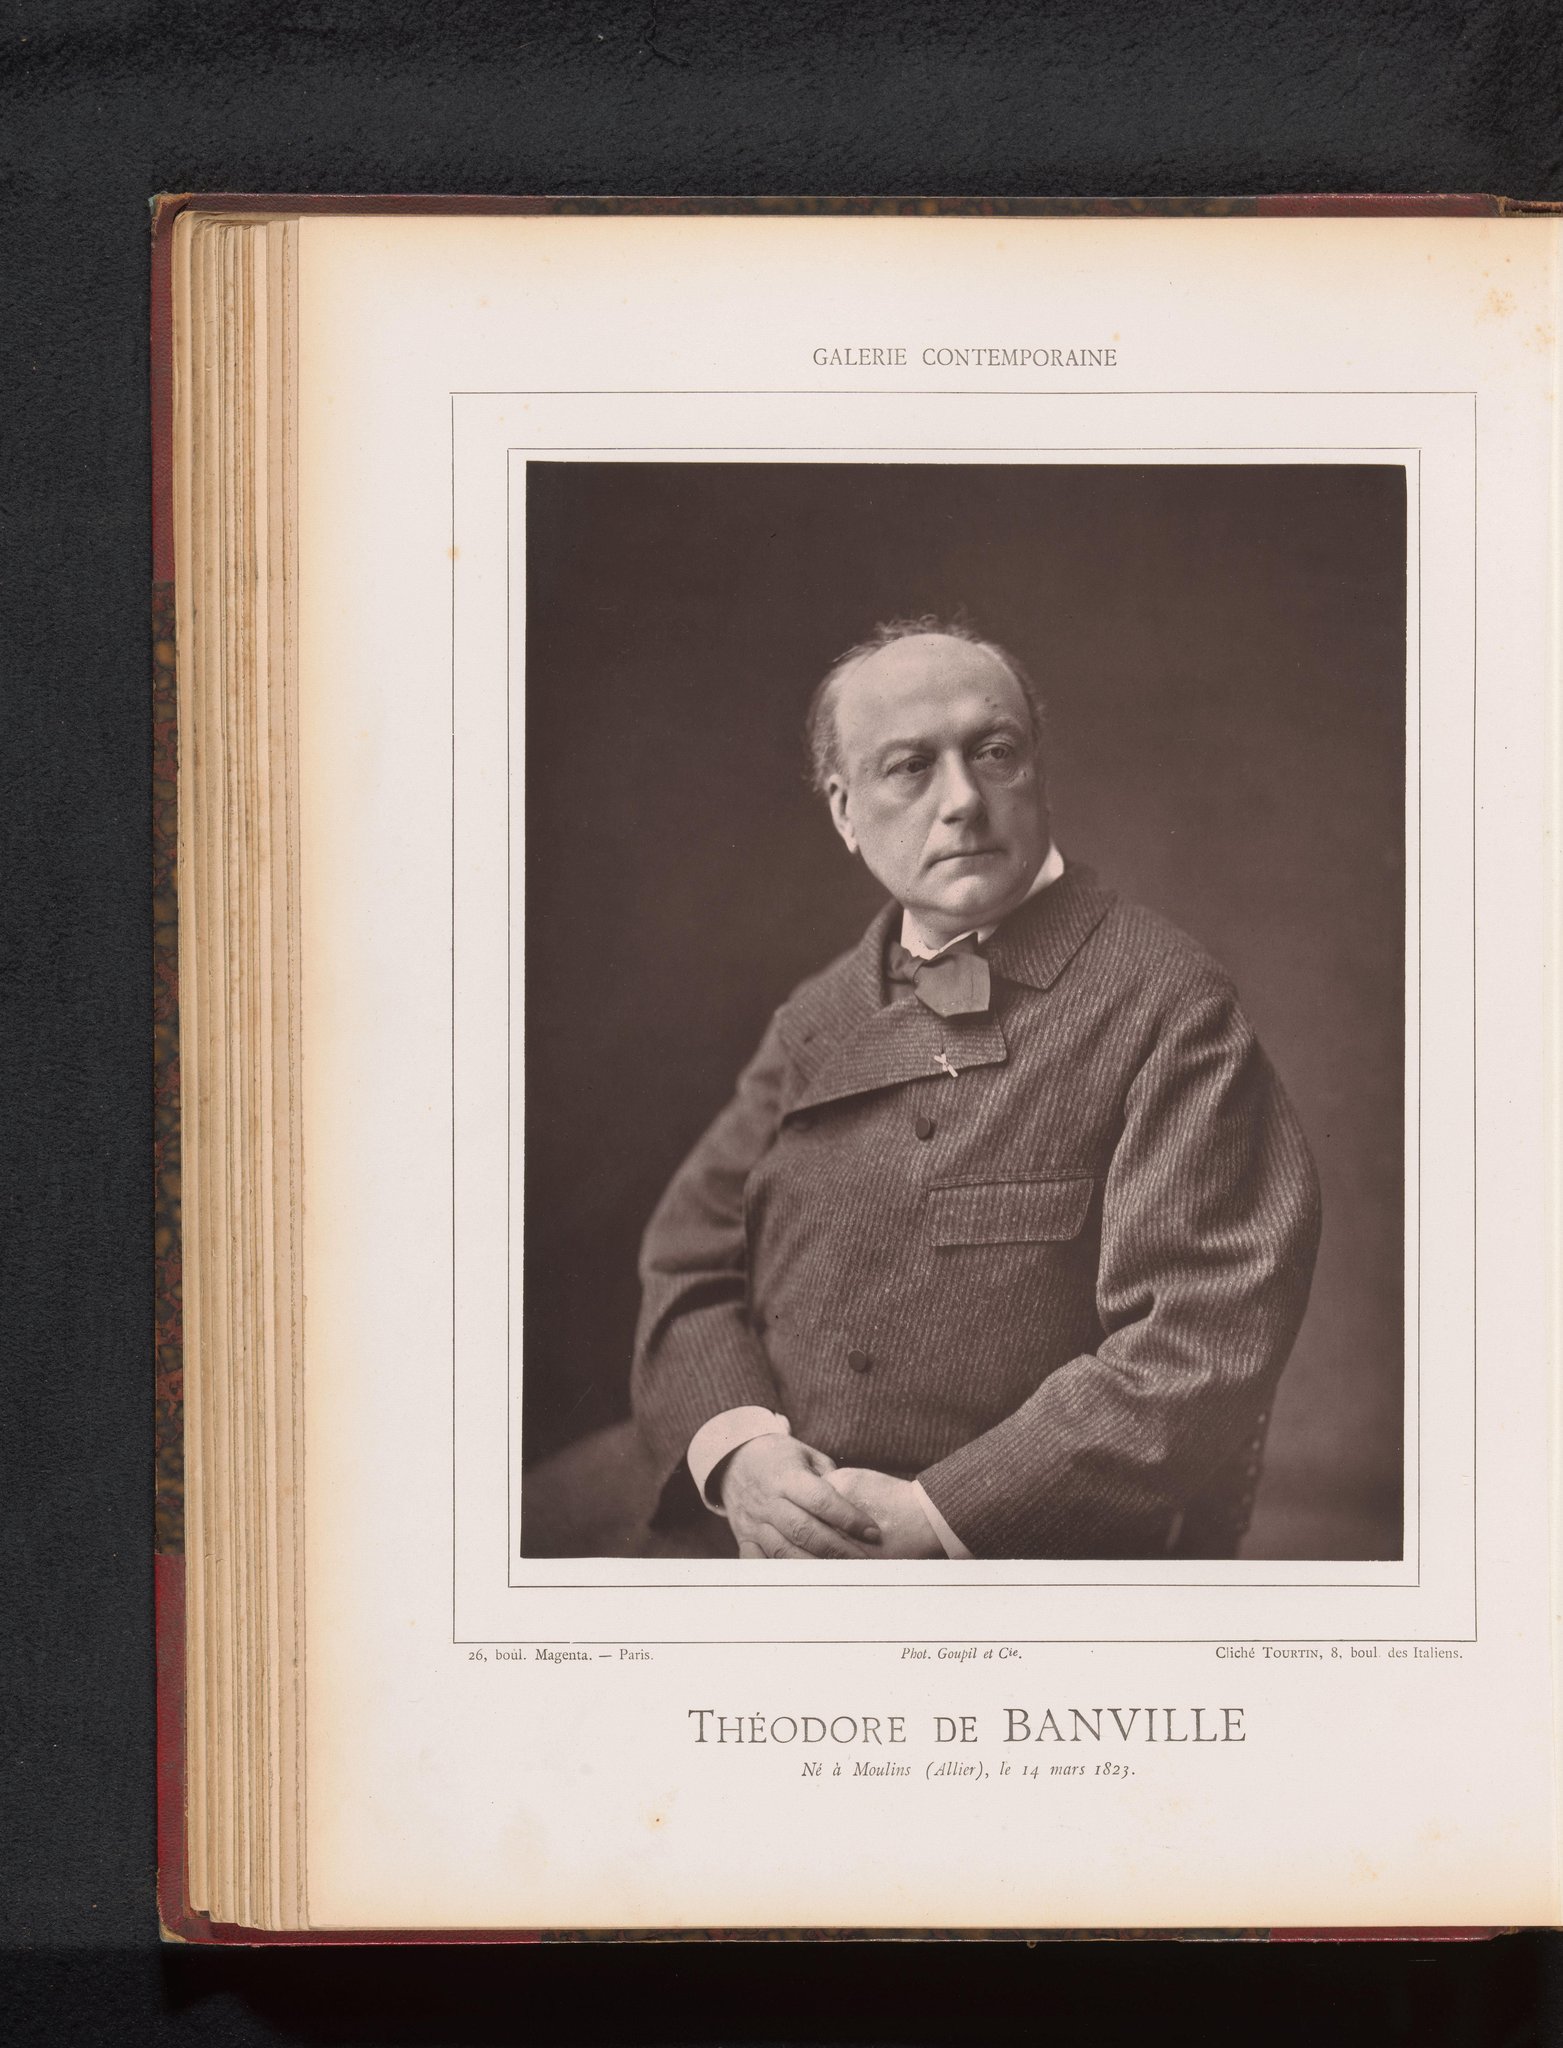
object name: photomechanical print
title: Théodore de Banville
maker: emile tourtin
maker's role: fotograaf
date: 1873-1878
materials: paper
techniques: woodburytype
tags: historical persons, portrait of a writer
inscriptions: inscription: ‘Né à Moulins (Allier), le 14 mars 1823.’